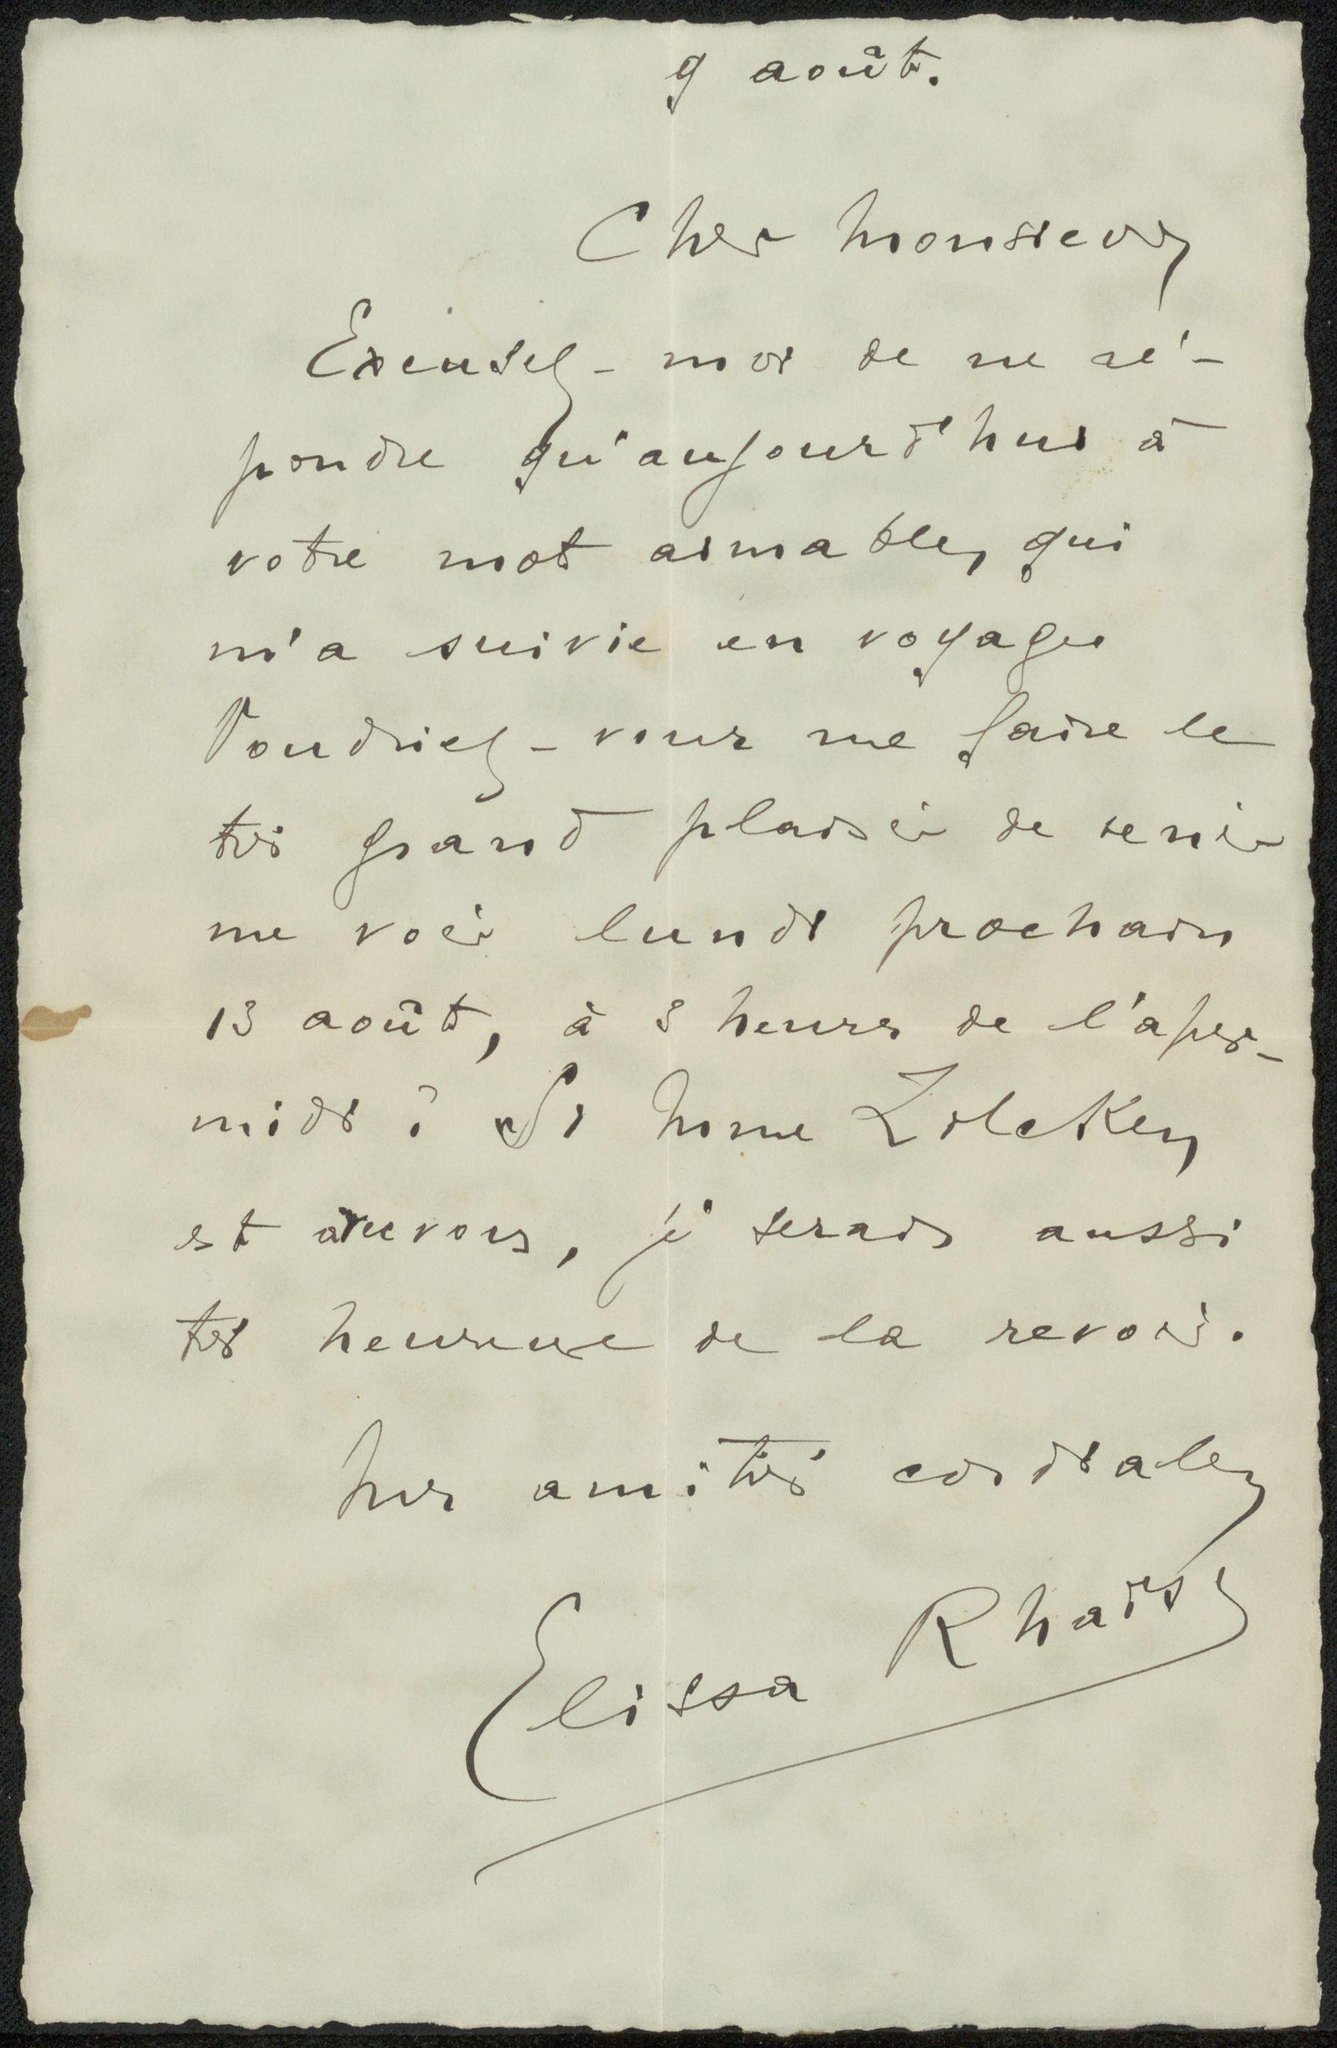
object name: letter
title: Brief aan Philip Zilcken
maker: elissa rhaïs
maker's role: romanschrijver, schrijver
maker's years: 1876-1940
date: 1928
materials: ink, paper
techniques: pen, writing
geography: paris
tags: the hague, painter, draughtsman, philip zilcken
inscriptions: collector's mark: ‘RPK’